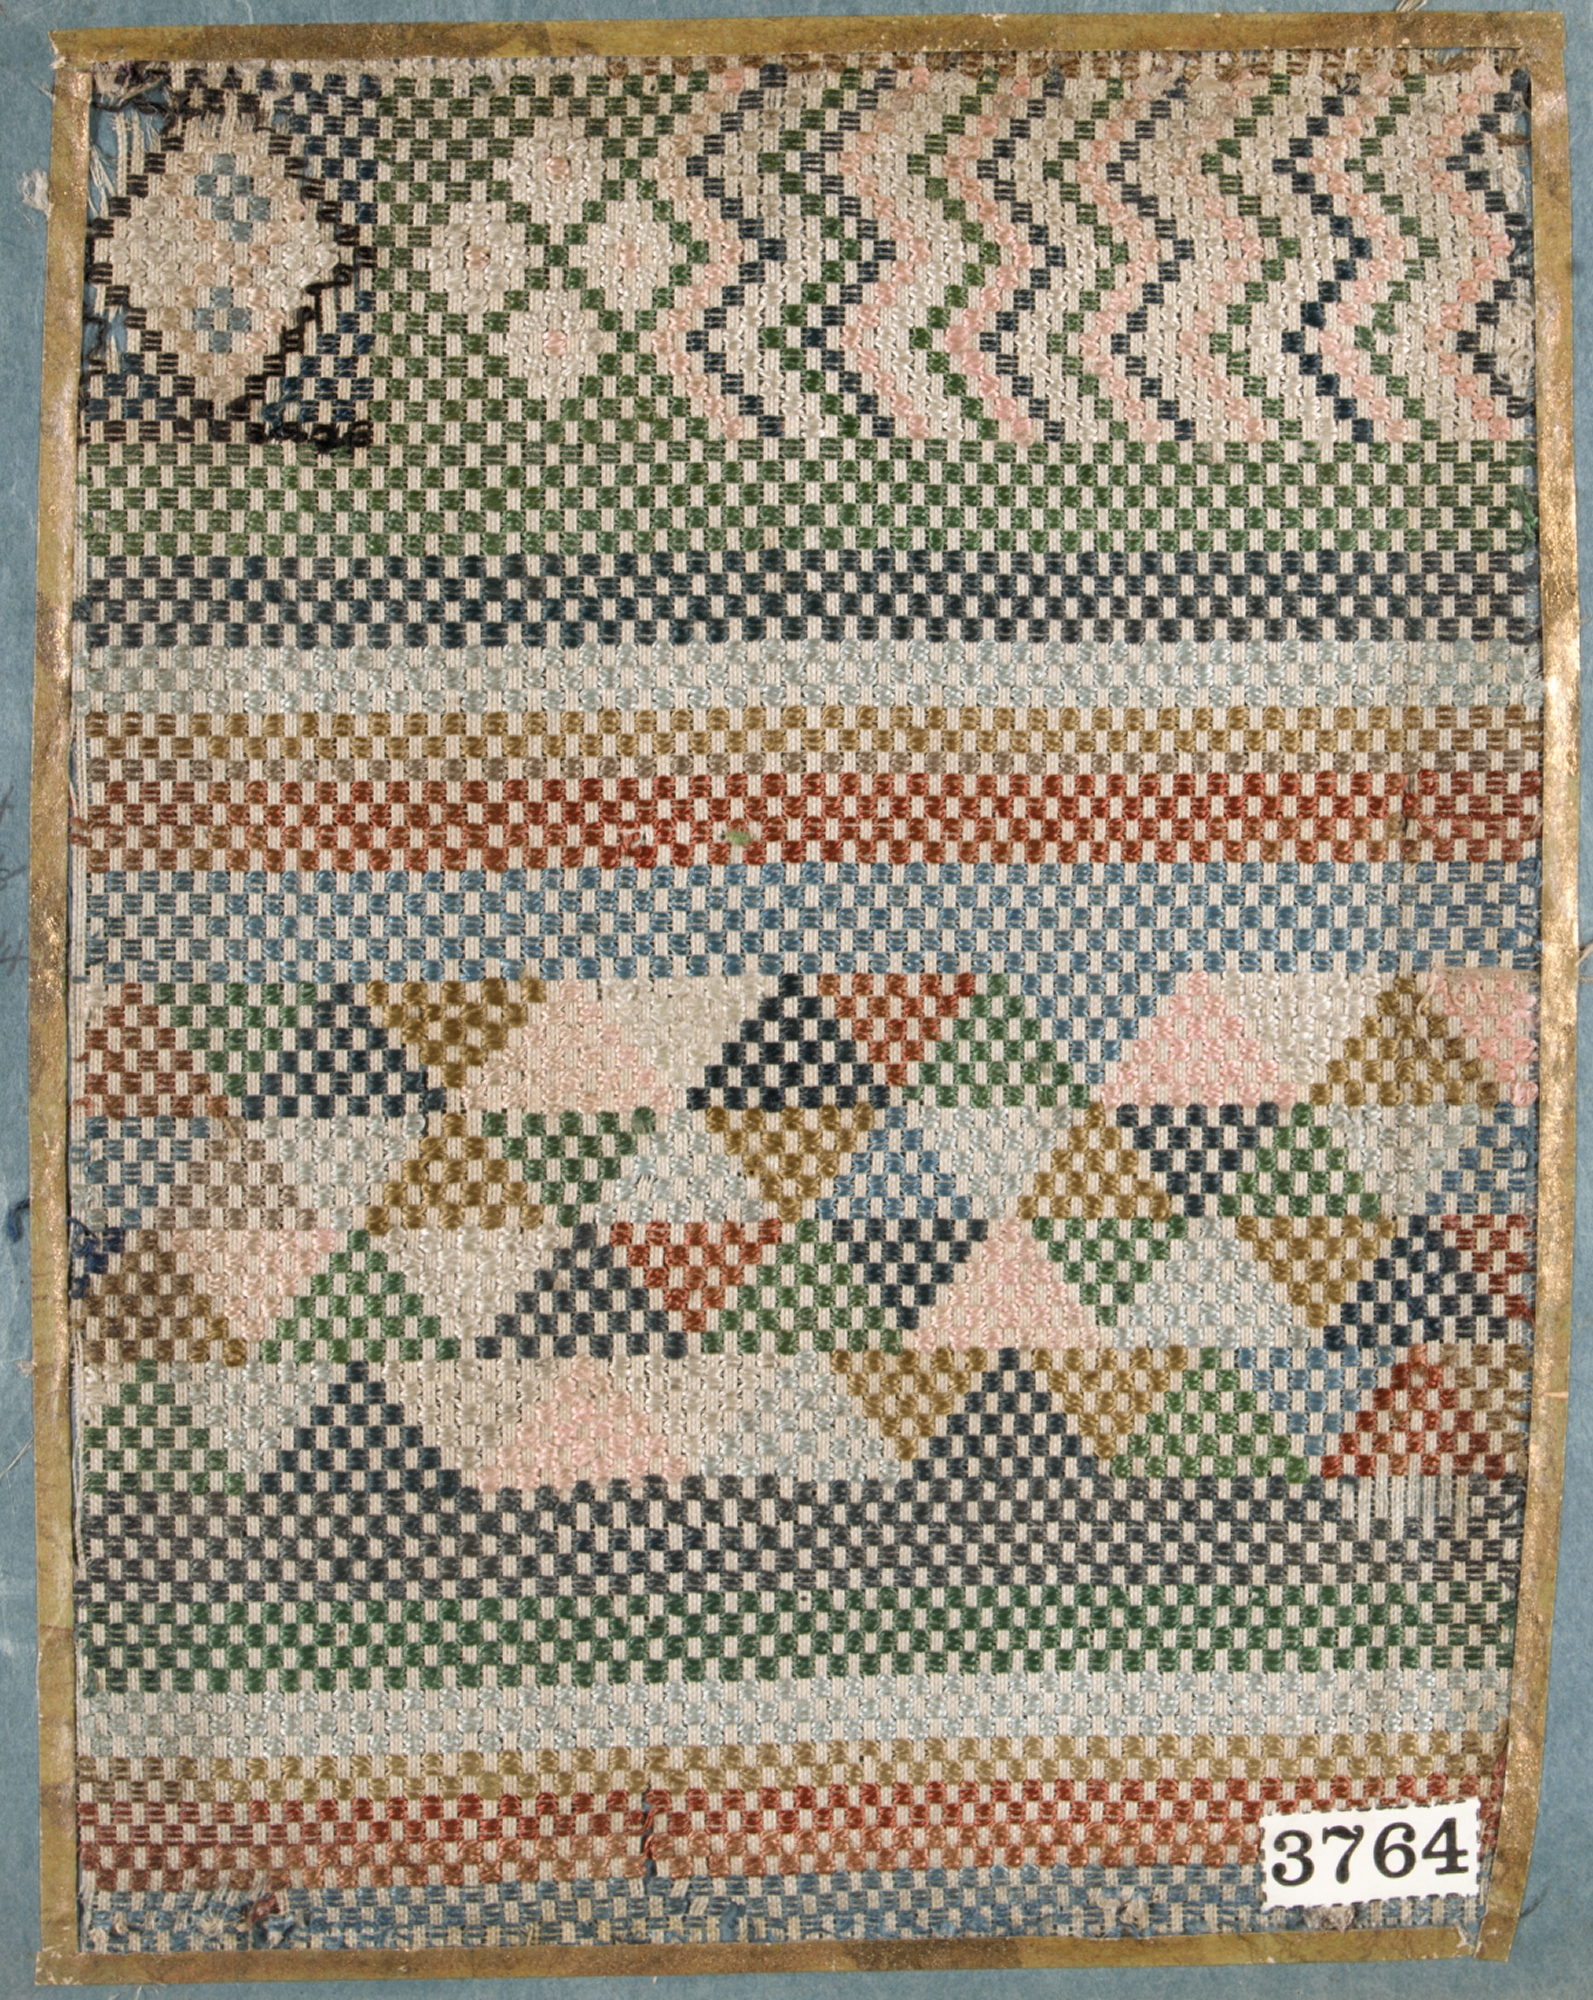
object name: sample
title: Textile Sample from Sample Book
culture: japanese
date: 1801-1900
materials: silk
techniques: tapestry